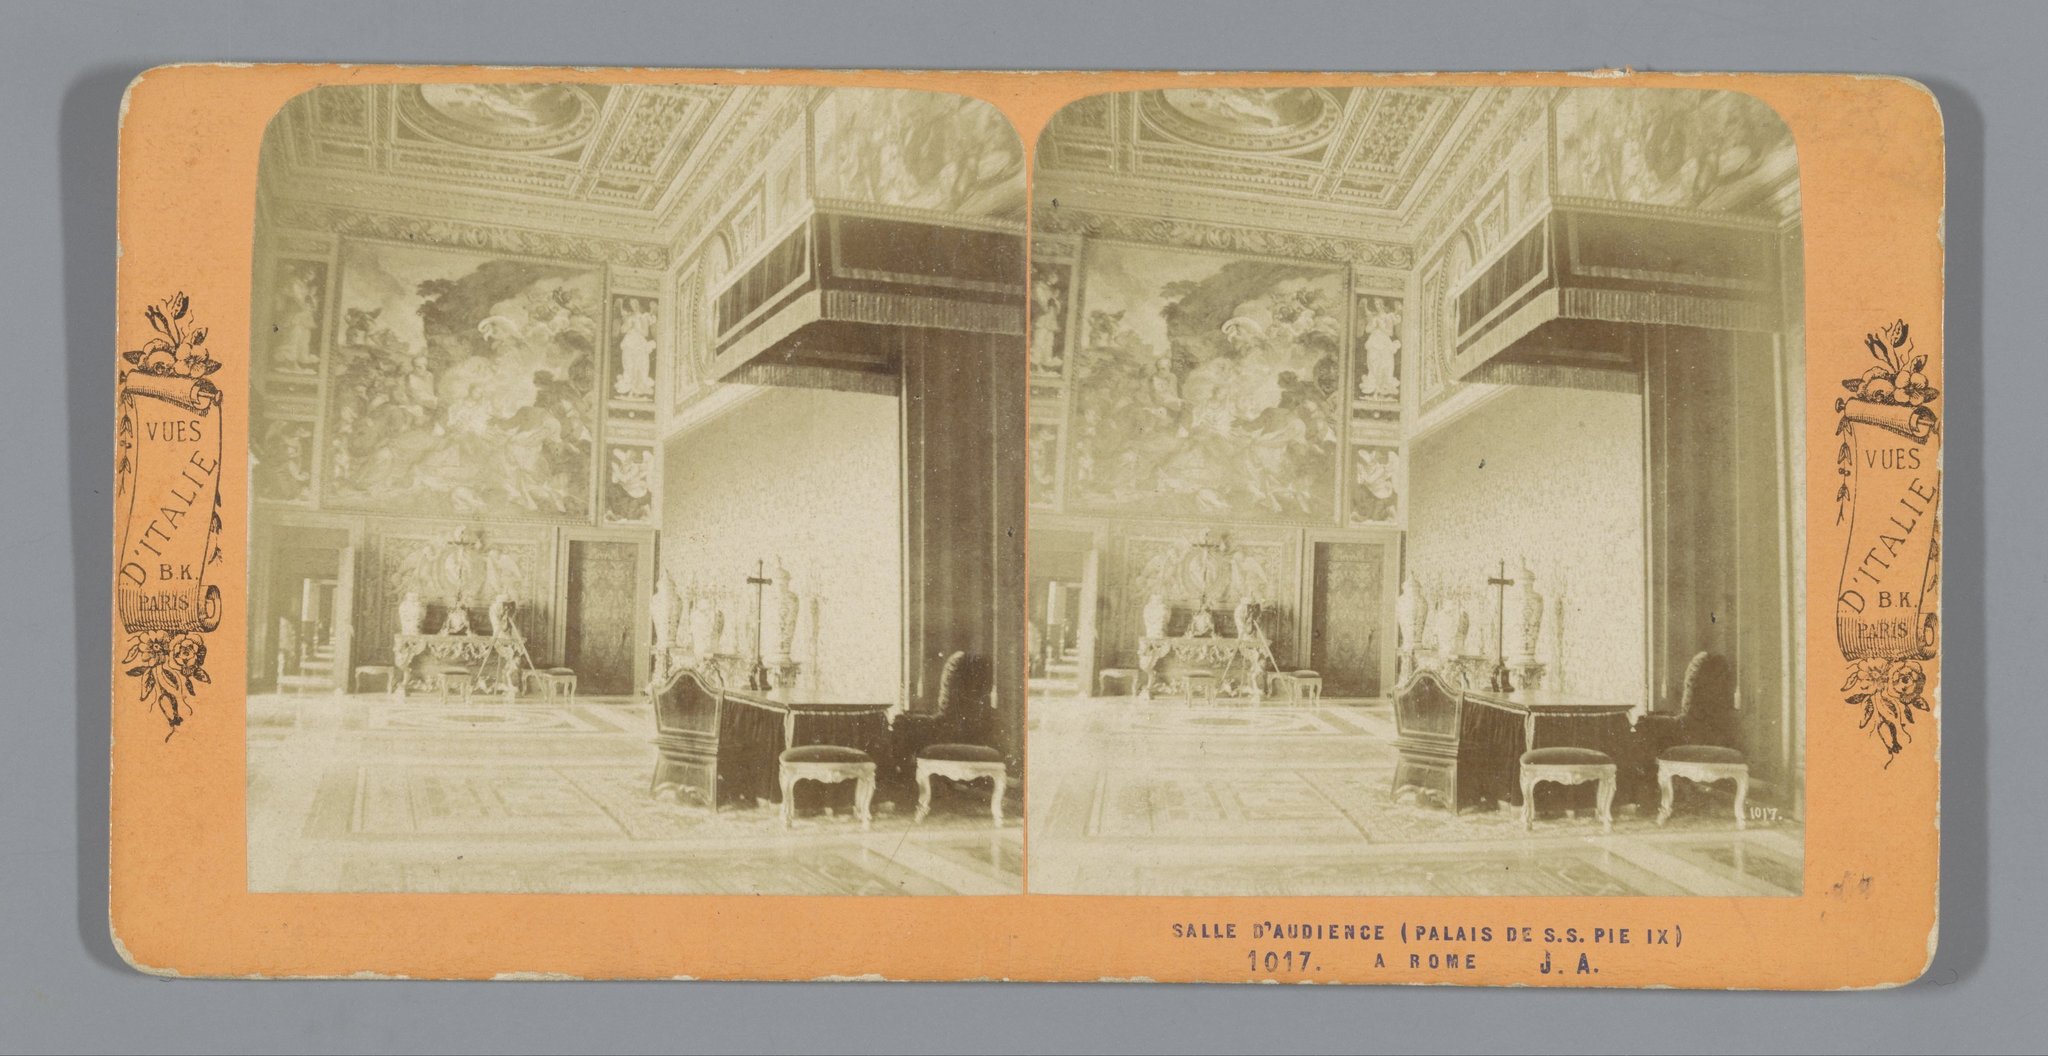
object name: stereograph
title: Interieur van de ambtskamer van paus Pius IX in het Apostolisch Paleis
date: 1872-1876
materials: cardboard, paper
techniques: albumen print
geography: paris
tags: palace - aa - civic architecture: inside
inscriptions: number: ‘1017’